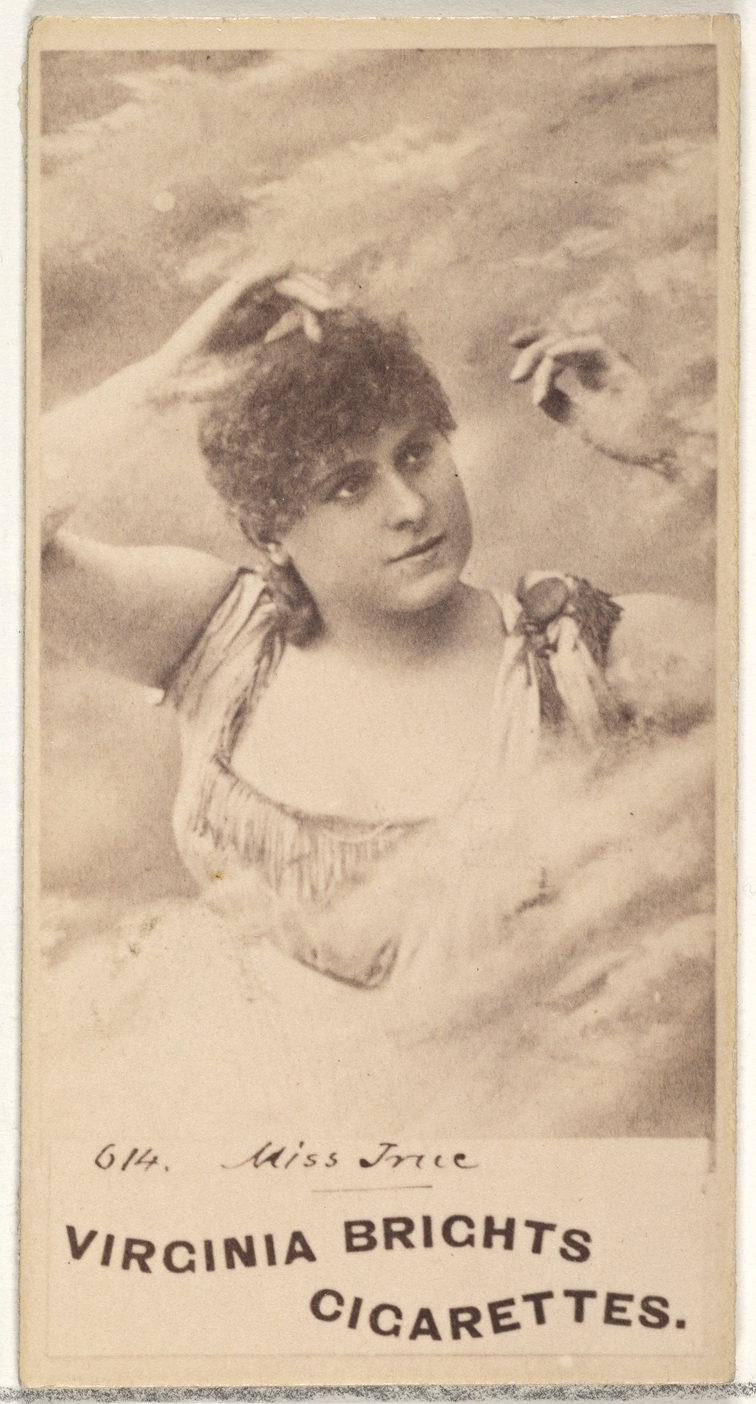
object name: photograph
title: Card 614, Miss True, from the Actors and Actresses series (N45, Type 1) for Virginia Brights Cigarettes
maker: allen & ginter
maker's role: publisher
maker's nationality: american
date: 1888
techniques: albumen silver print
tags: portraits,women,actresses